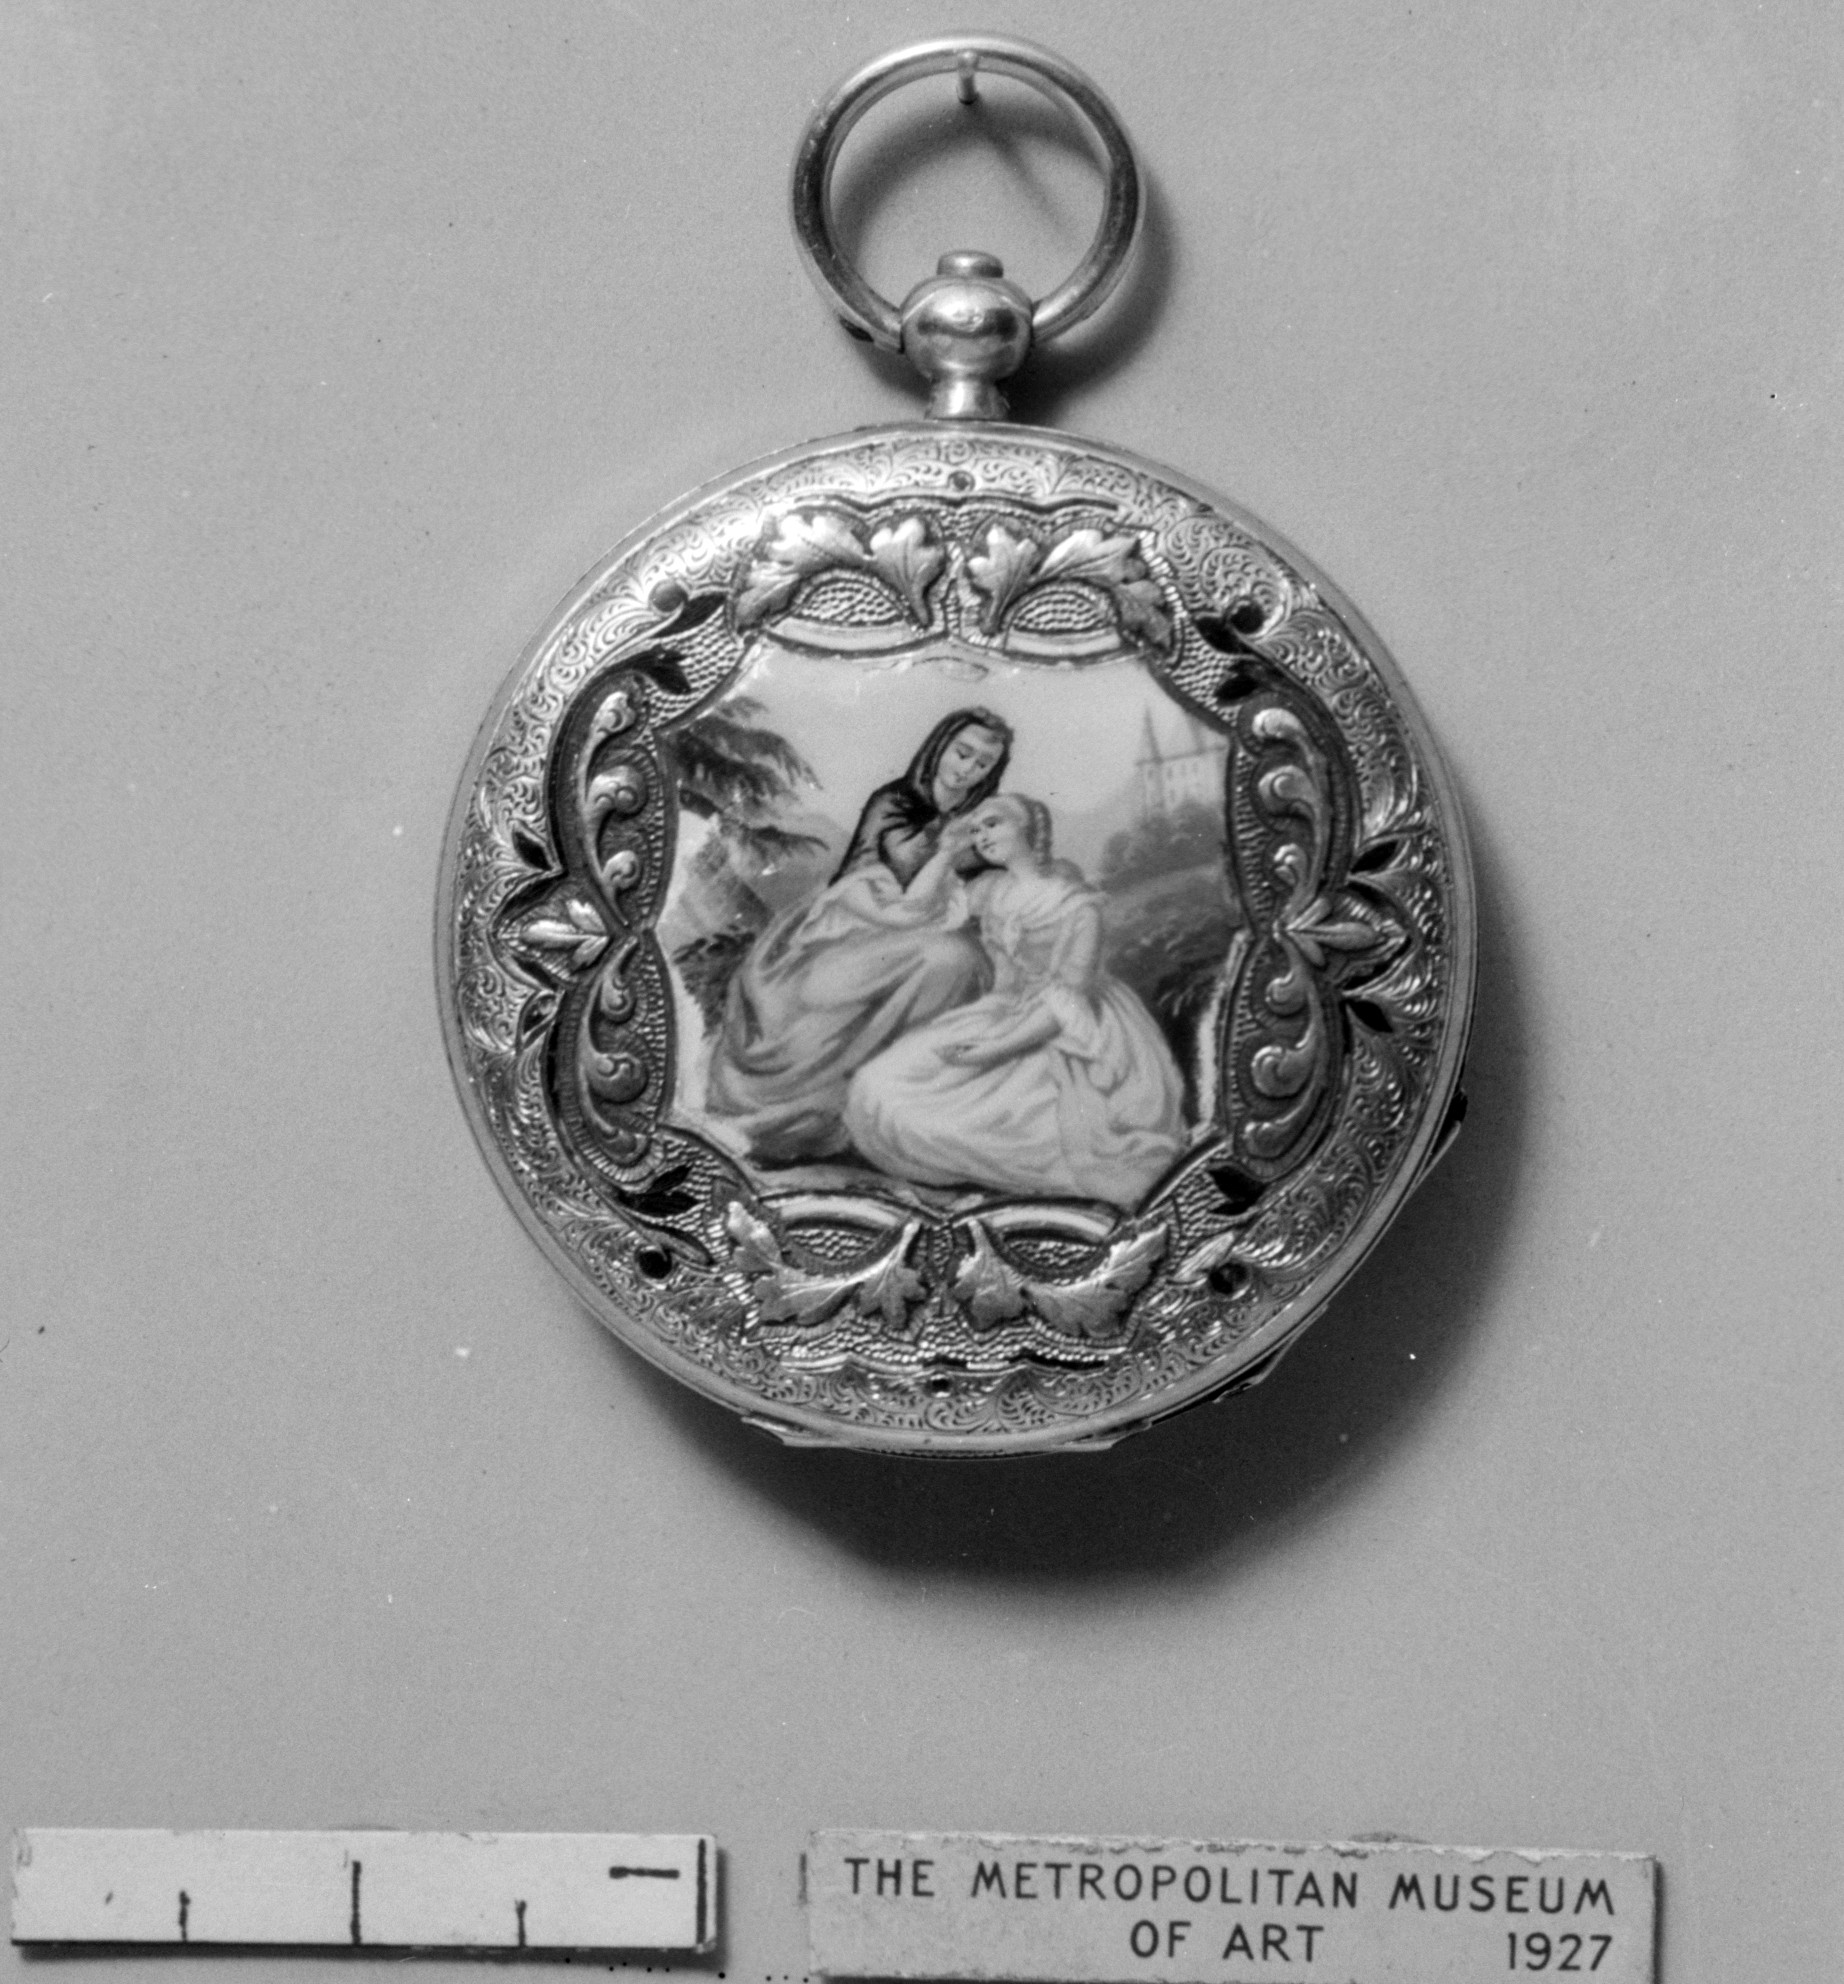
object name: watch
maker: bolviller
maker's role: maker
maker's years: 1800-1900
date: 1840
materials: enamel, gold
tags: girls,women